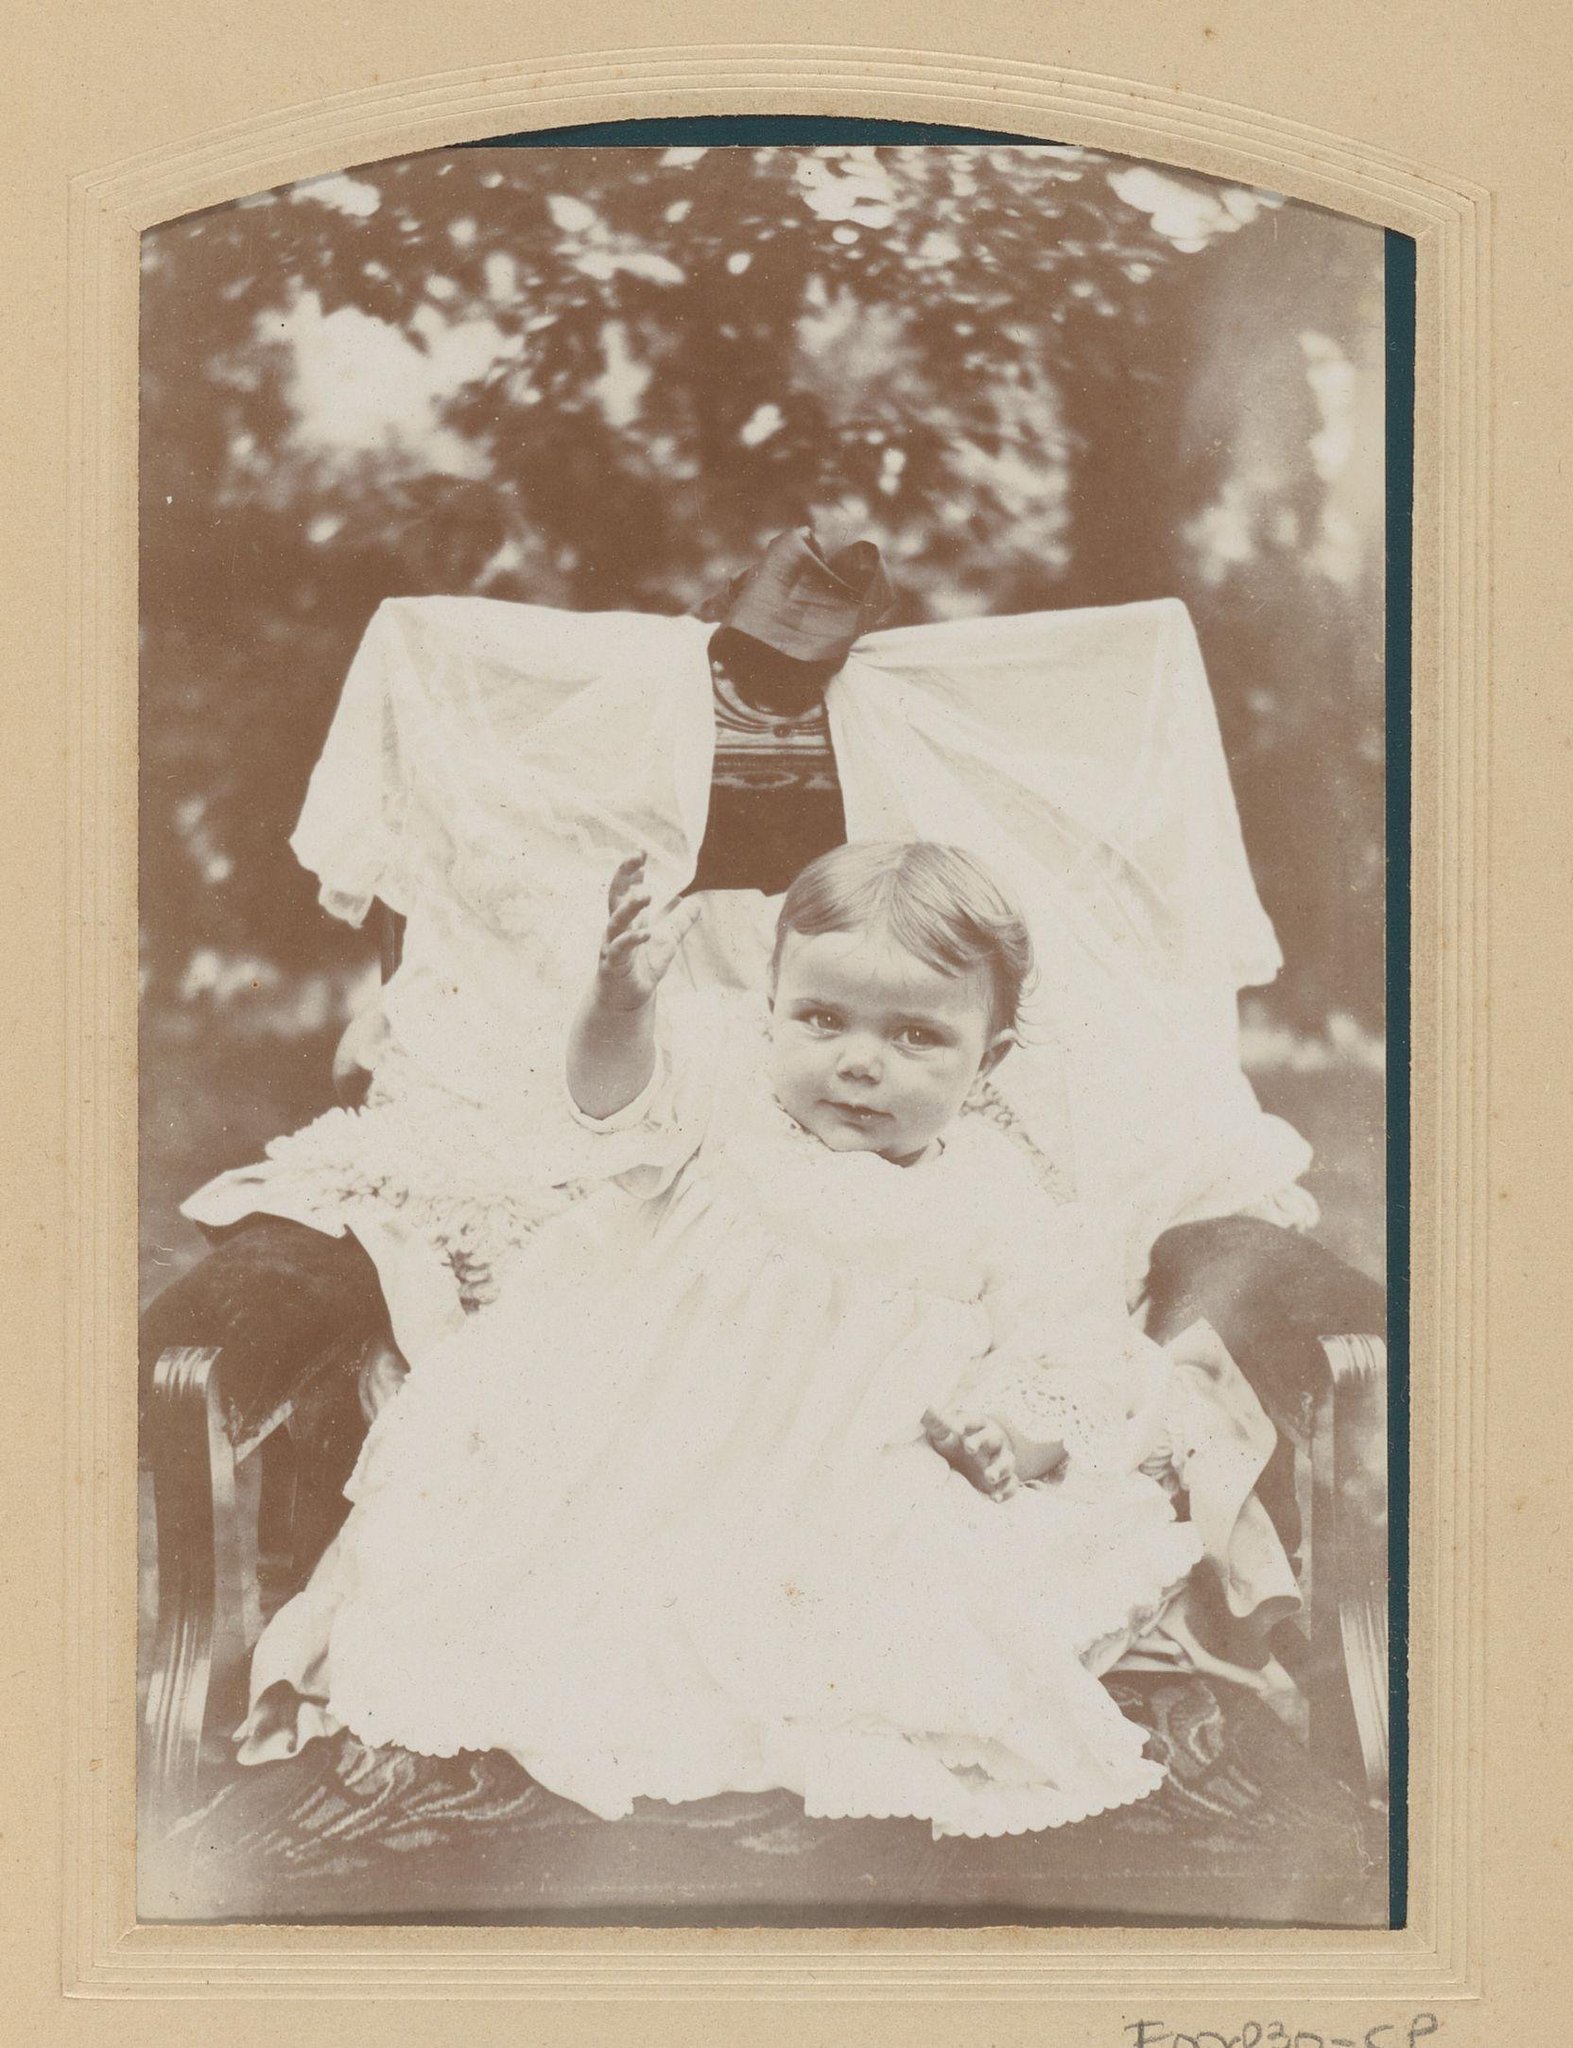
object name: cabinet photograph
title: Portret van een peuter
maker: Anonymous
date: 1890-1910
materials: cardboard, photographic support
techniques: collodion silver print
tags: toddler, historical persons